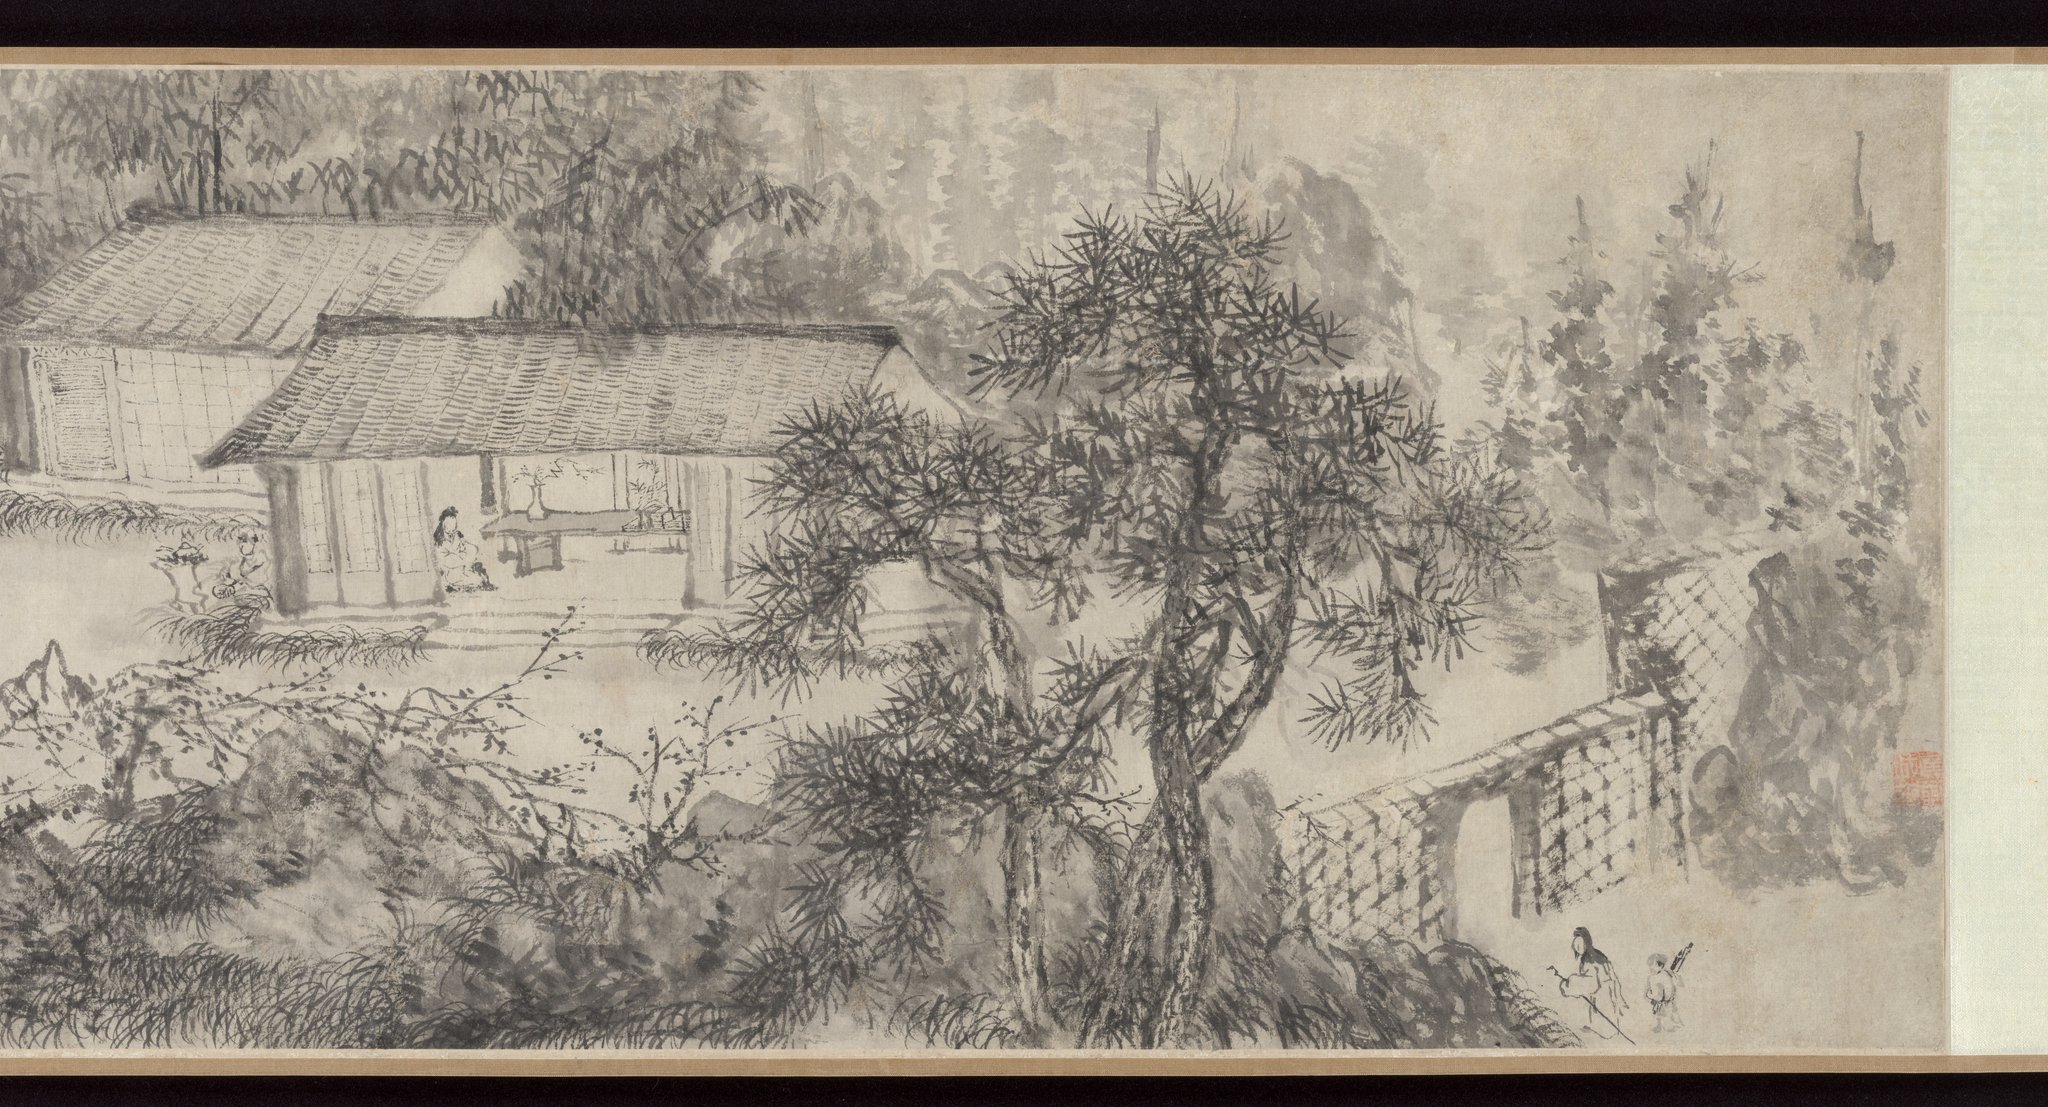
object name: handscroll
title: The Studio of Prolonged Soughing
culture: chinese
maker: you yin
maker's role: artist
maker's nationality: chinese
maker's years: 1732-1812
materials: ink, paper